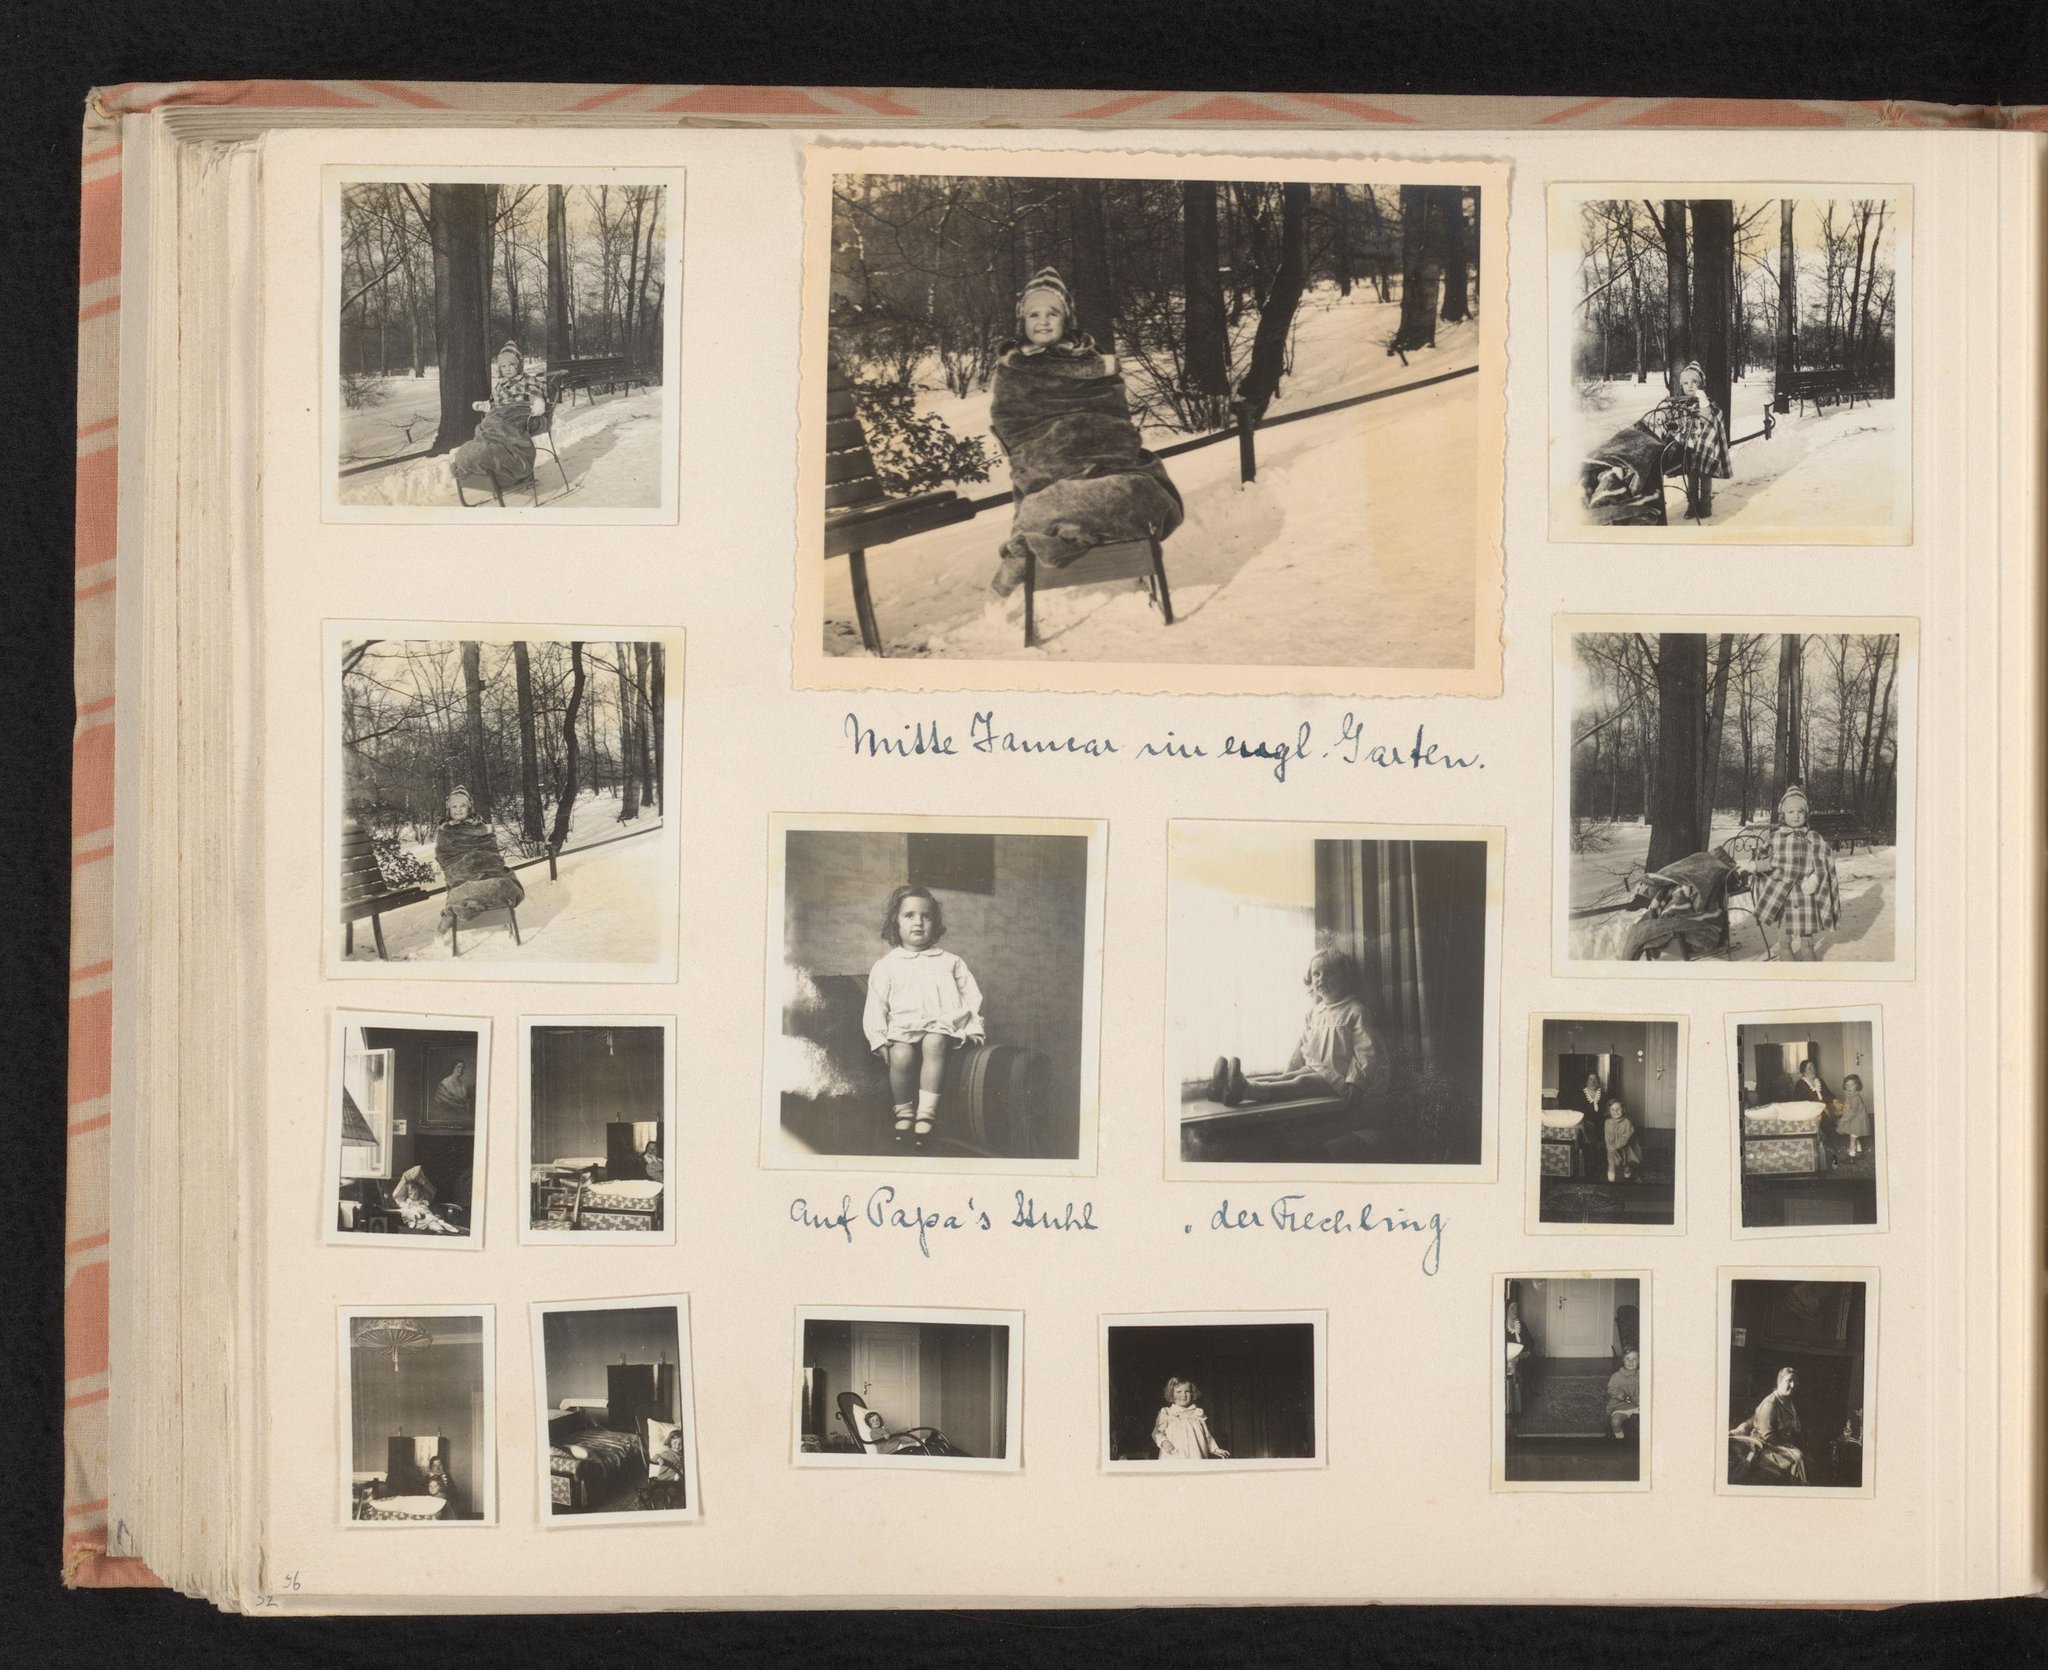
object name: photograph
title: Isabel Wachenheimer in een slee in een winters landschap, en met haar moeder Else Wachenheimer-Moos in huiselijk tafereel, januari 1931, München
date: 1901-1931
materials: paper, photographic support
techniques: gelatin silver print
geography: munich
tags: else wachenheimer-moos, leiden, isabel wachenheimer-elon, family life at home, mother and baby or young child, sledge, sleigh (winter sports), infant, baby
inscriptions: inscription: ‘Mitte Januar in engl. Garten//auf Papa's stuhl ,,der Frechling"’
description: Albumblad met zeventien foto's. Alle foto's, Isabel Wachenheimer. Kwartet foto's links onderin en kwartet rechts onderin, Else Wachenheimer-Moos (donkere kleding). Onderdeel van het fotoalbum met foto's van Isabel Wachenheimer als kind (1928-1931).